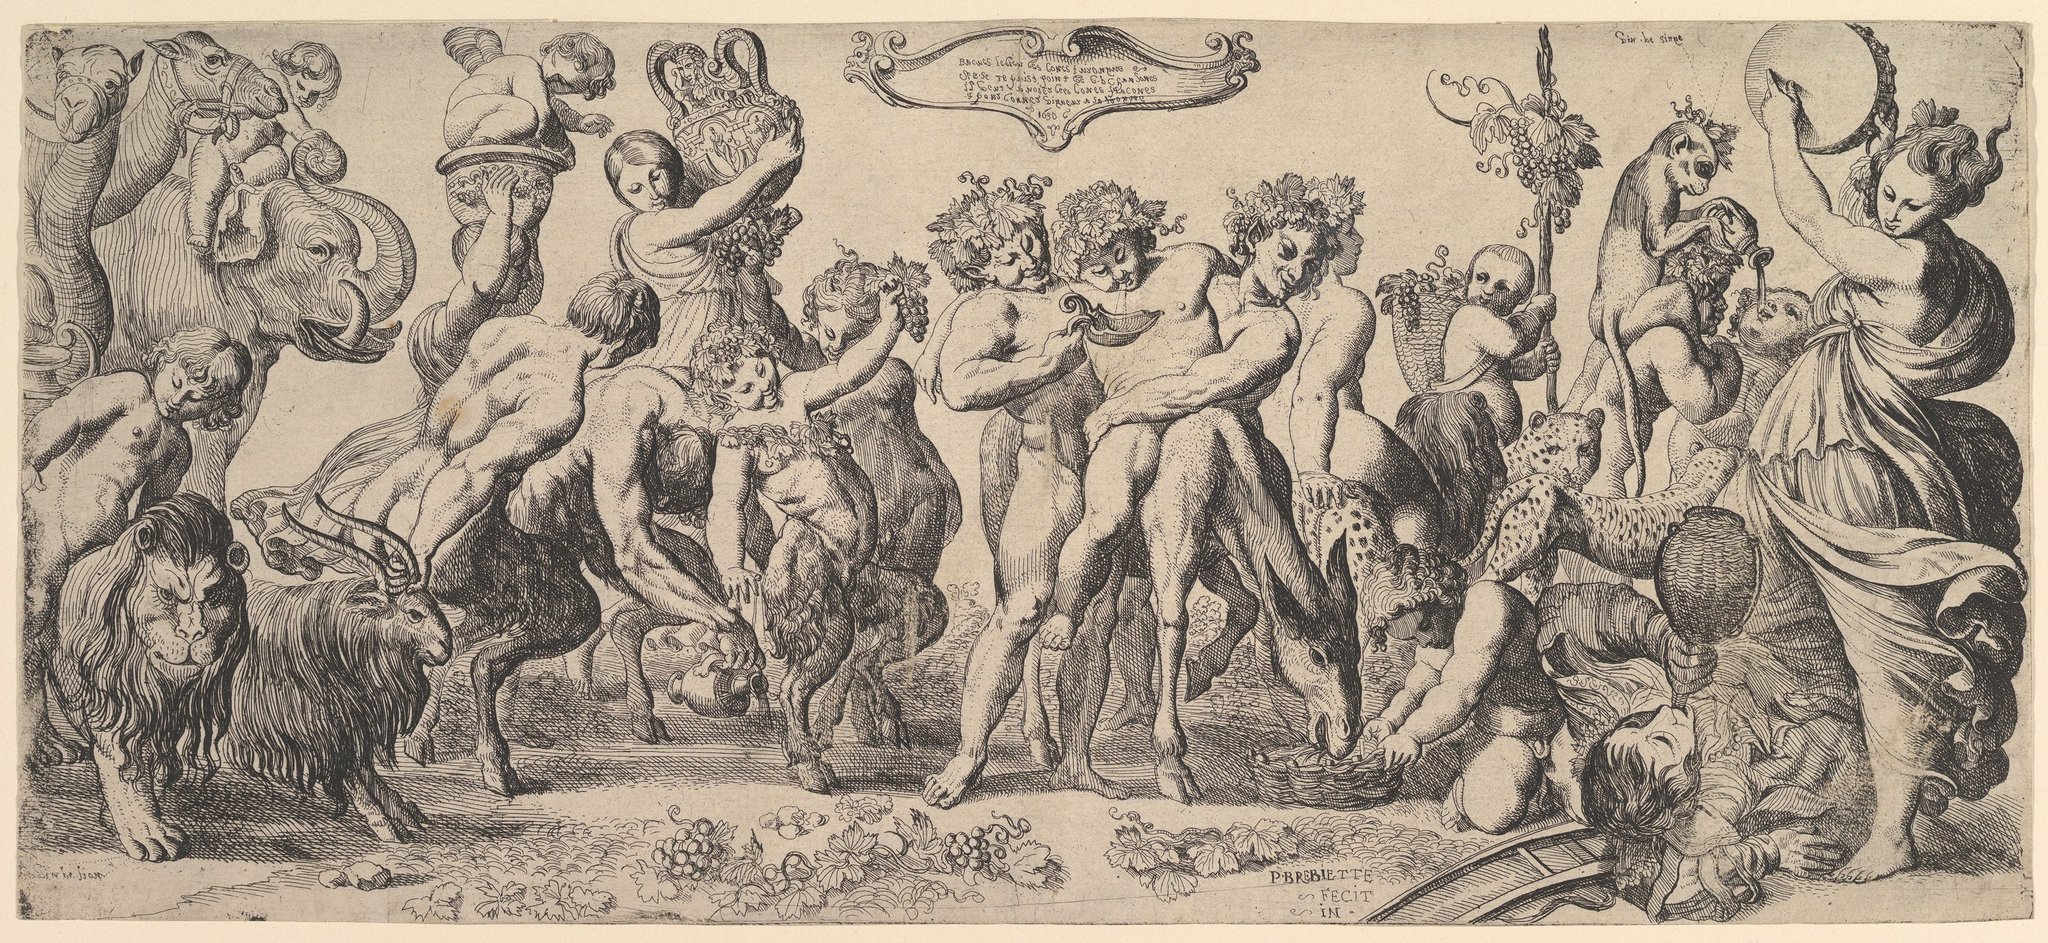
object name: print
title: Triumph of Bacchus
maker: pierre brebiette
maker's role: artist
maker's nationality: french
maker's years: 1598-1642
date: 1601-1700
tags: animals,centaurs,bacchus,lions,drinking